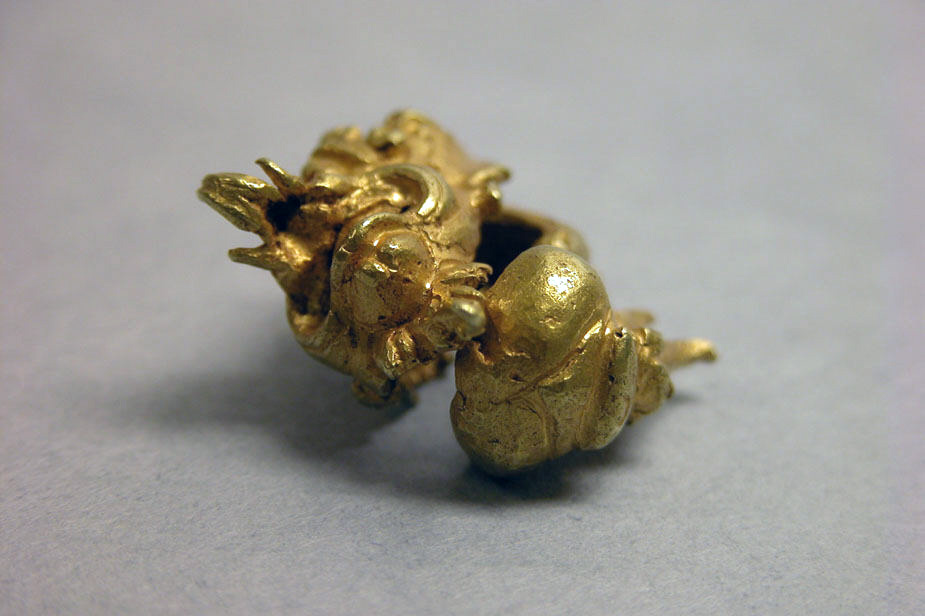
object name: ear ornament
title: Ear Ornament with Makara Motif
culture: indonesian, javanese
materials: gold